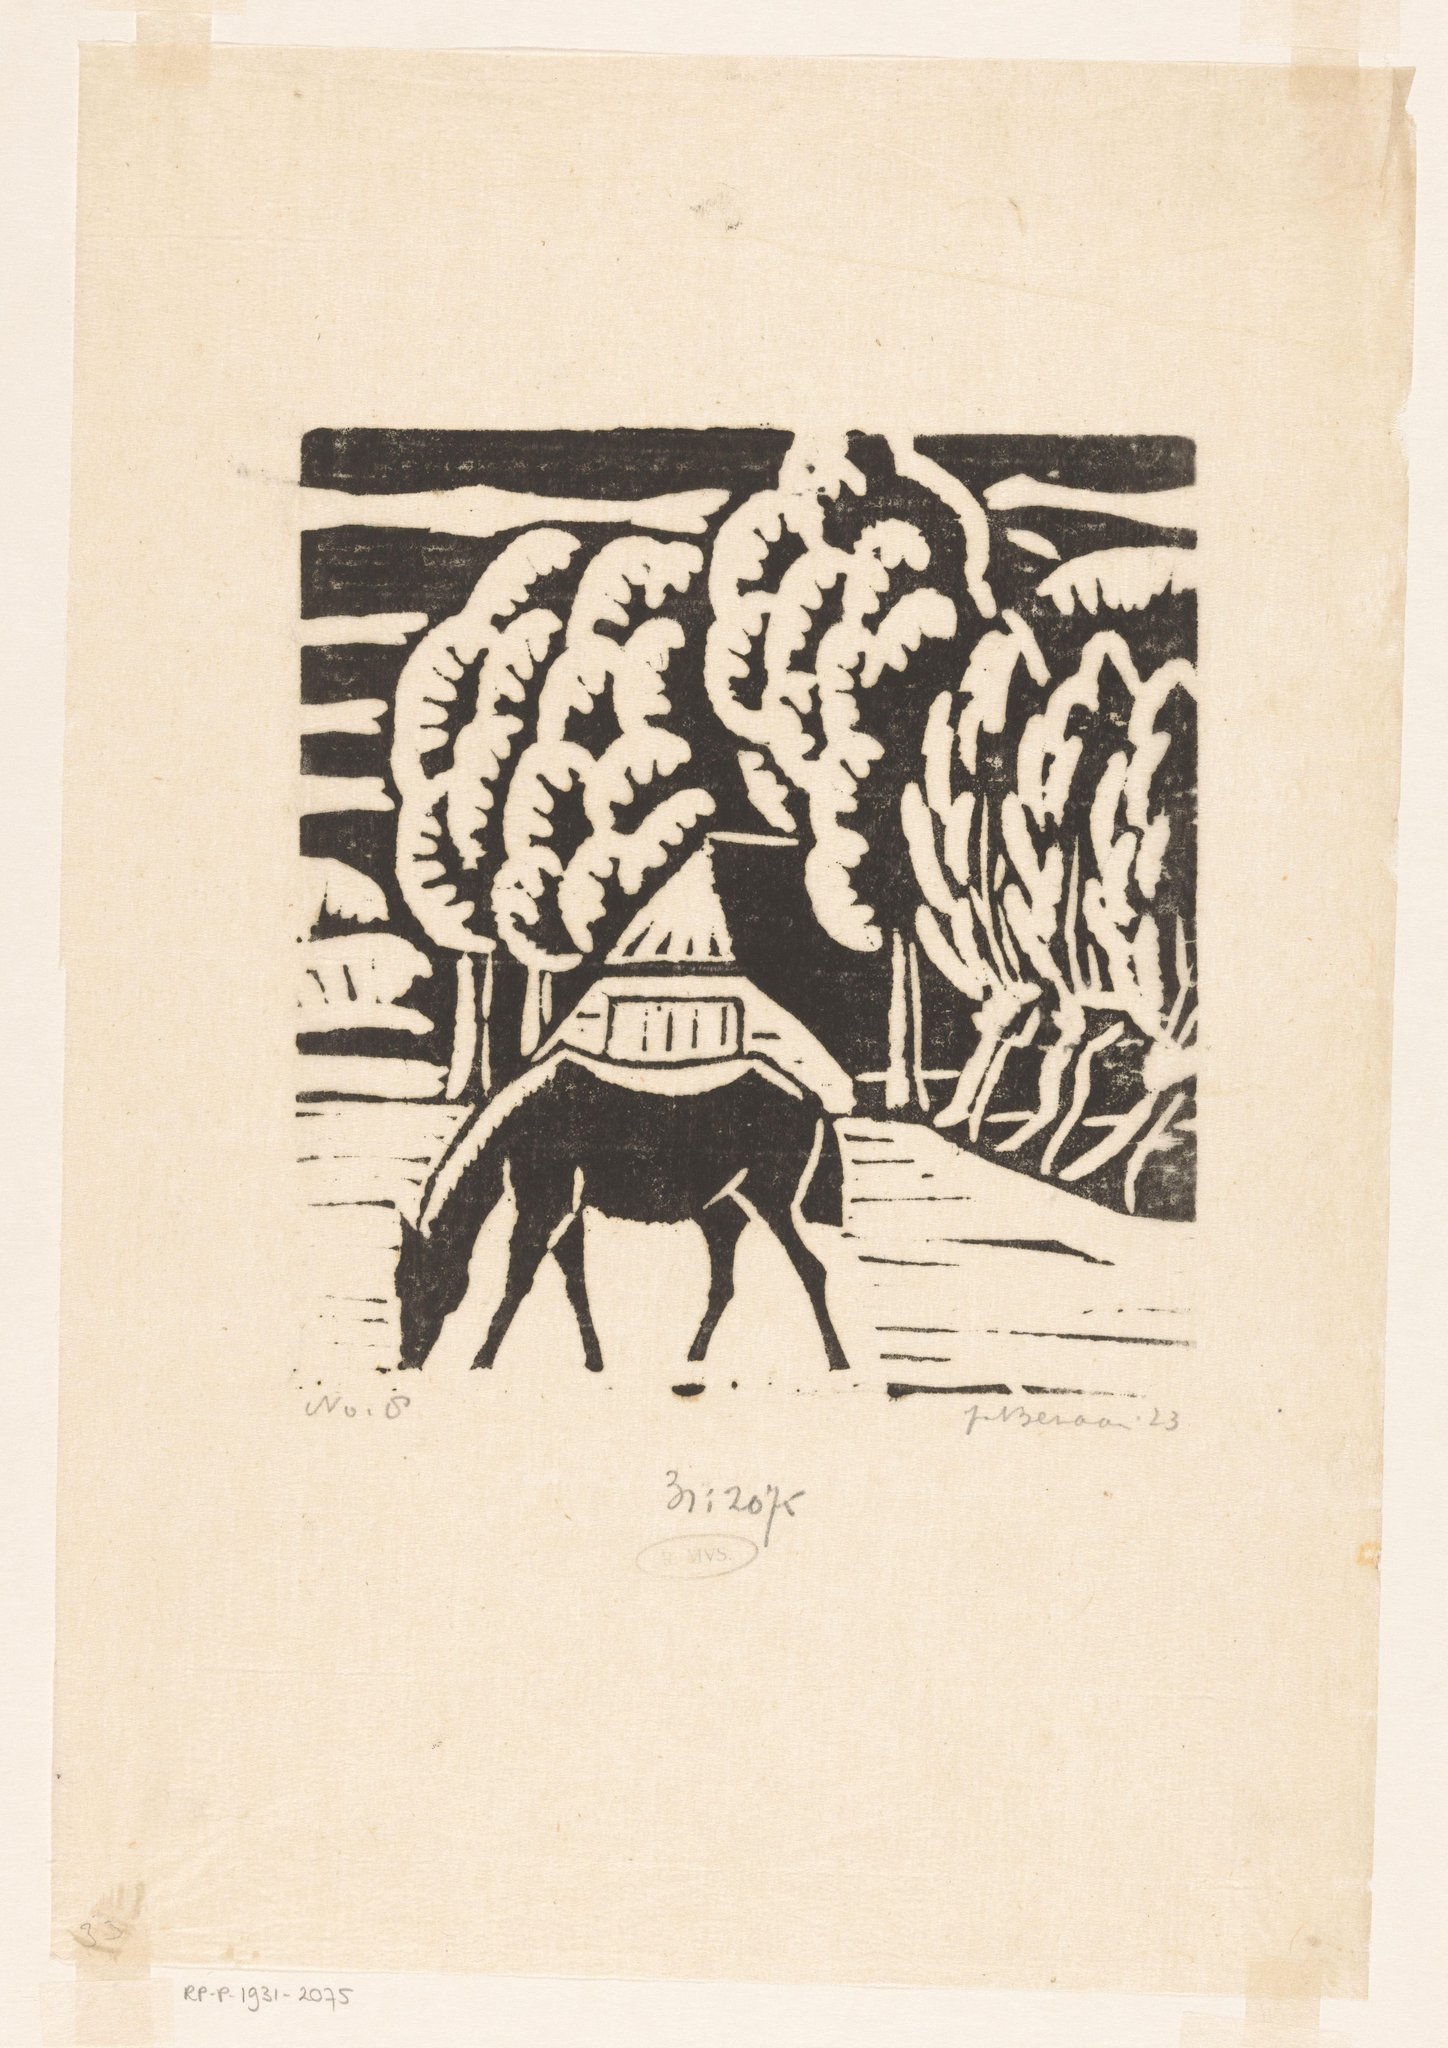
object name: print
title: Paard in de wei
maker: jo bezaan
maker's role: draughtsman, print maker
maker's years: 1894-1952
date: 1923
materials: paper, ink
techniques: woodcut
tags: horses and kindred animals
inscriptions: signature and date: ‘J. Bezaan '23’, number: ‘No. 8’, collector's mark: Lugt 2228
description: Grazend paard in de wei voor een boerderij.